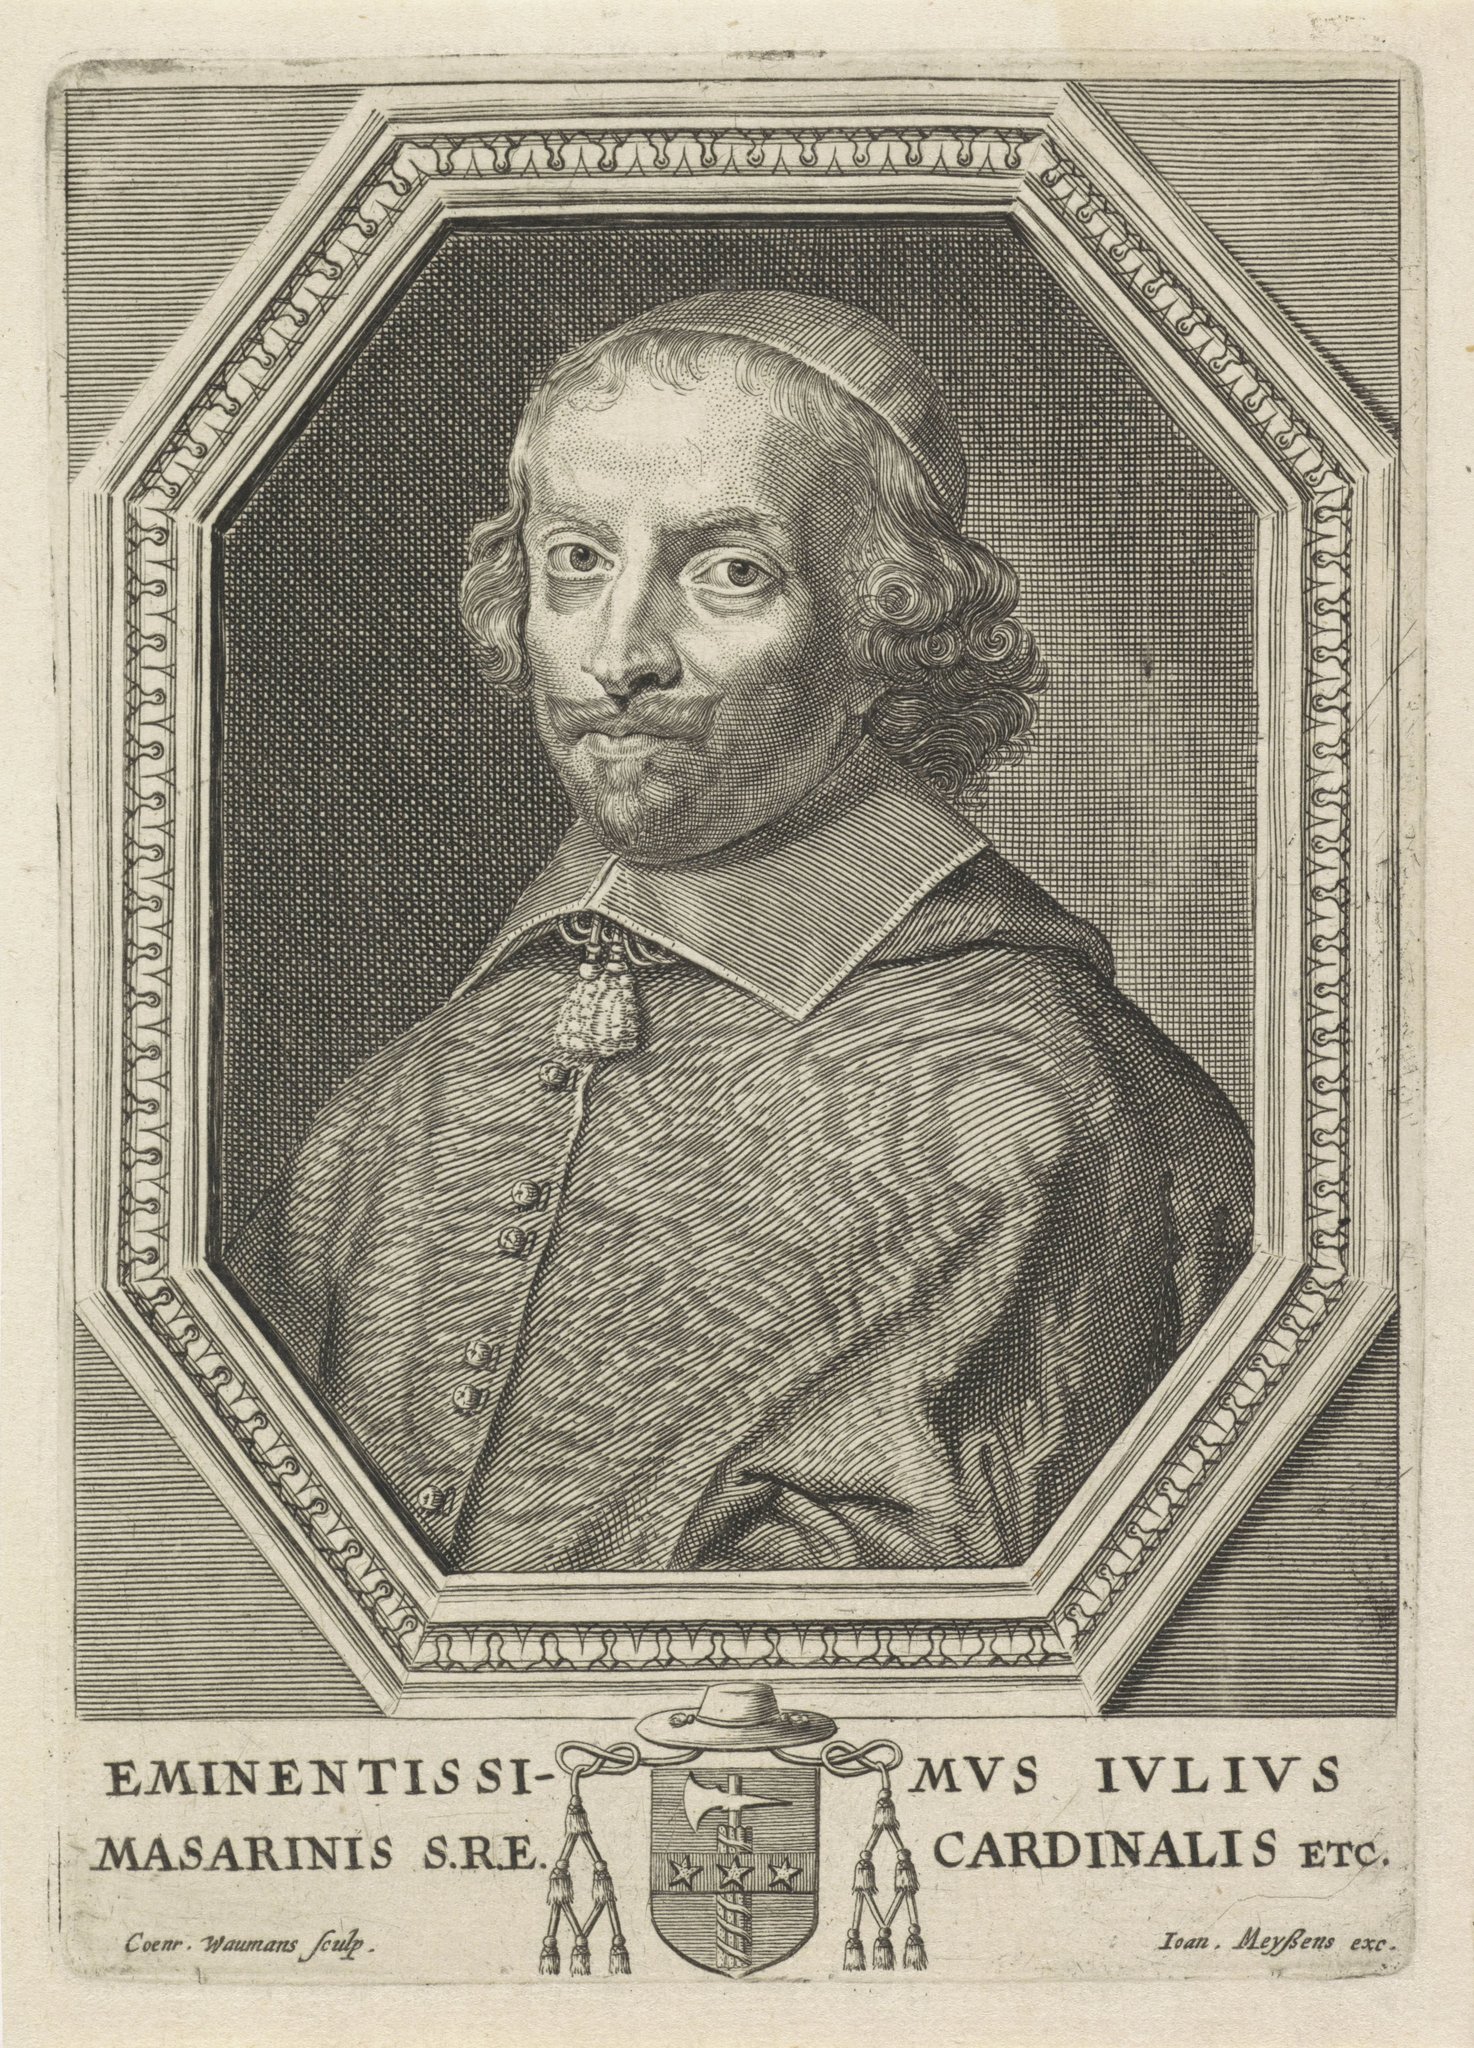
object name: print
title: Portret van de kardinaal Jules Mazarin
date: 1633-1673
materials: paper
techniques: engraving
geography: antwerp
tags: jules mazarin, cardinal, armorial bearing, heraldry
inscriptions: collector's mark: Lugt 2228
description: Portret van de kardinaal Jules Mazarin. In de marge zijn kardinaalswapen en een tweeregelig onderschrift in het Latijn.